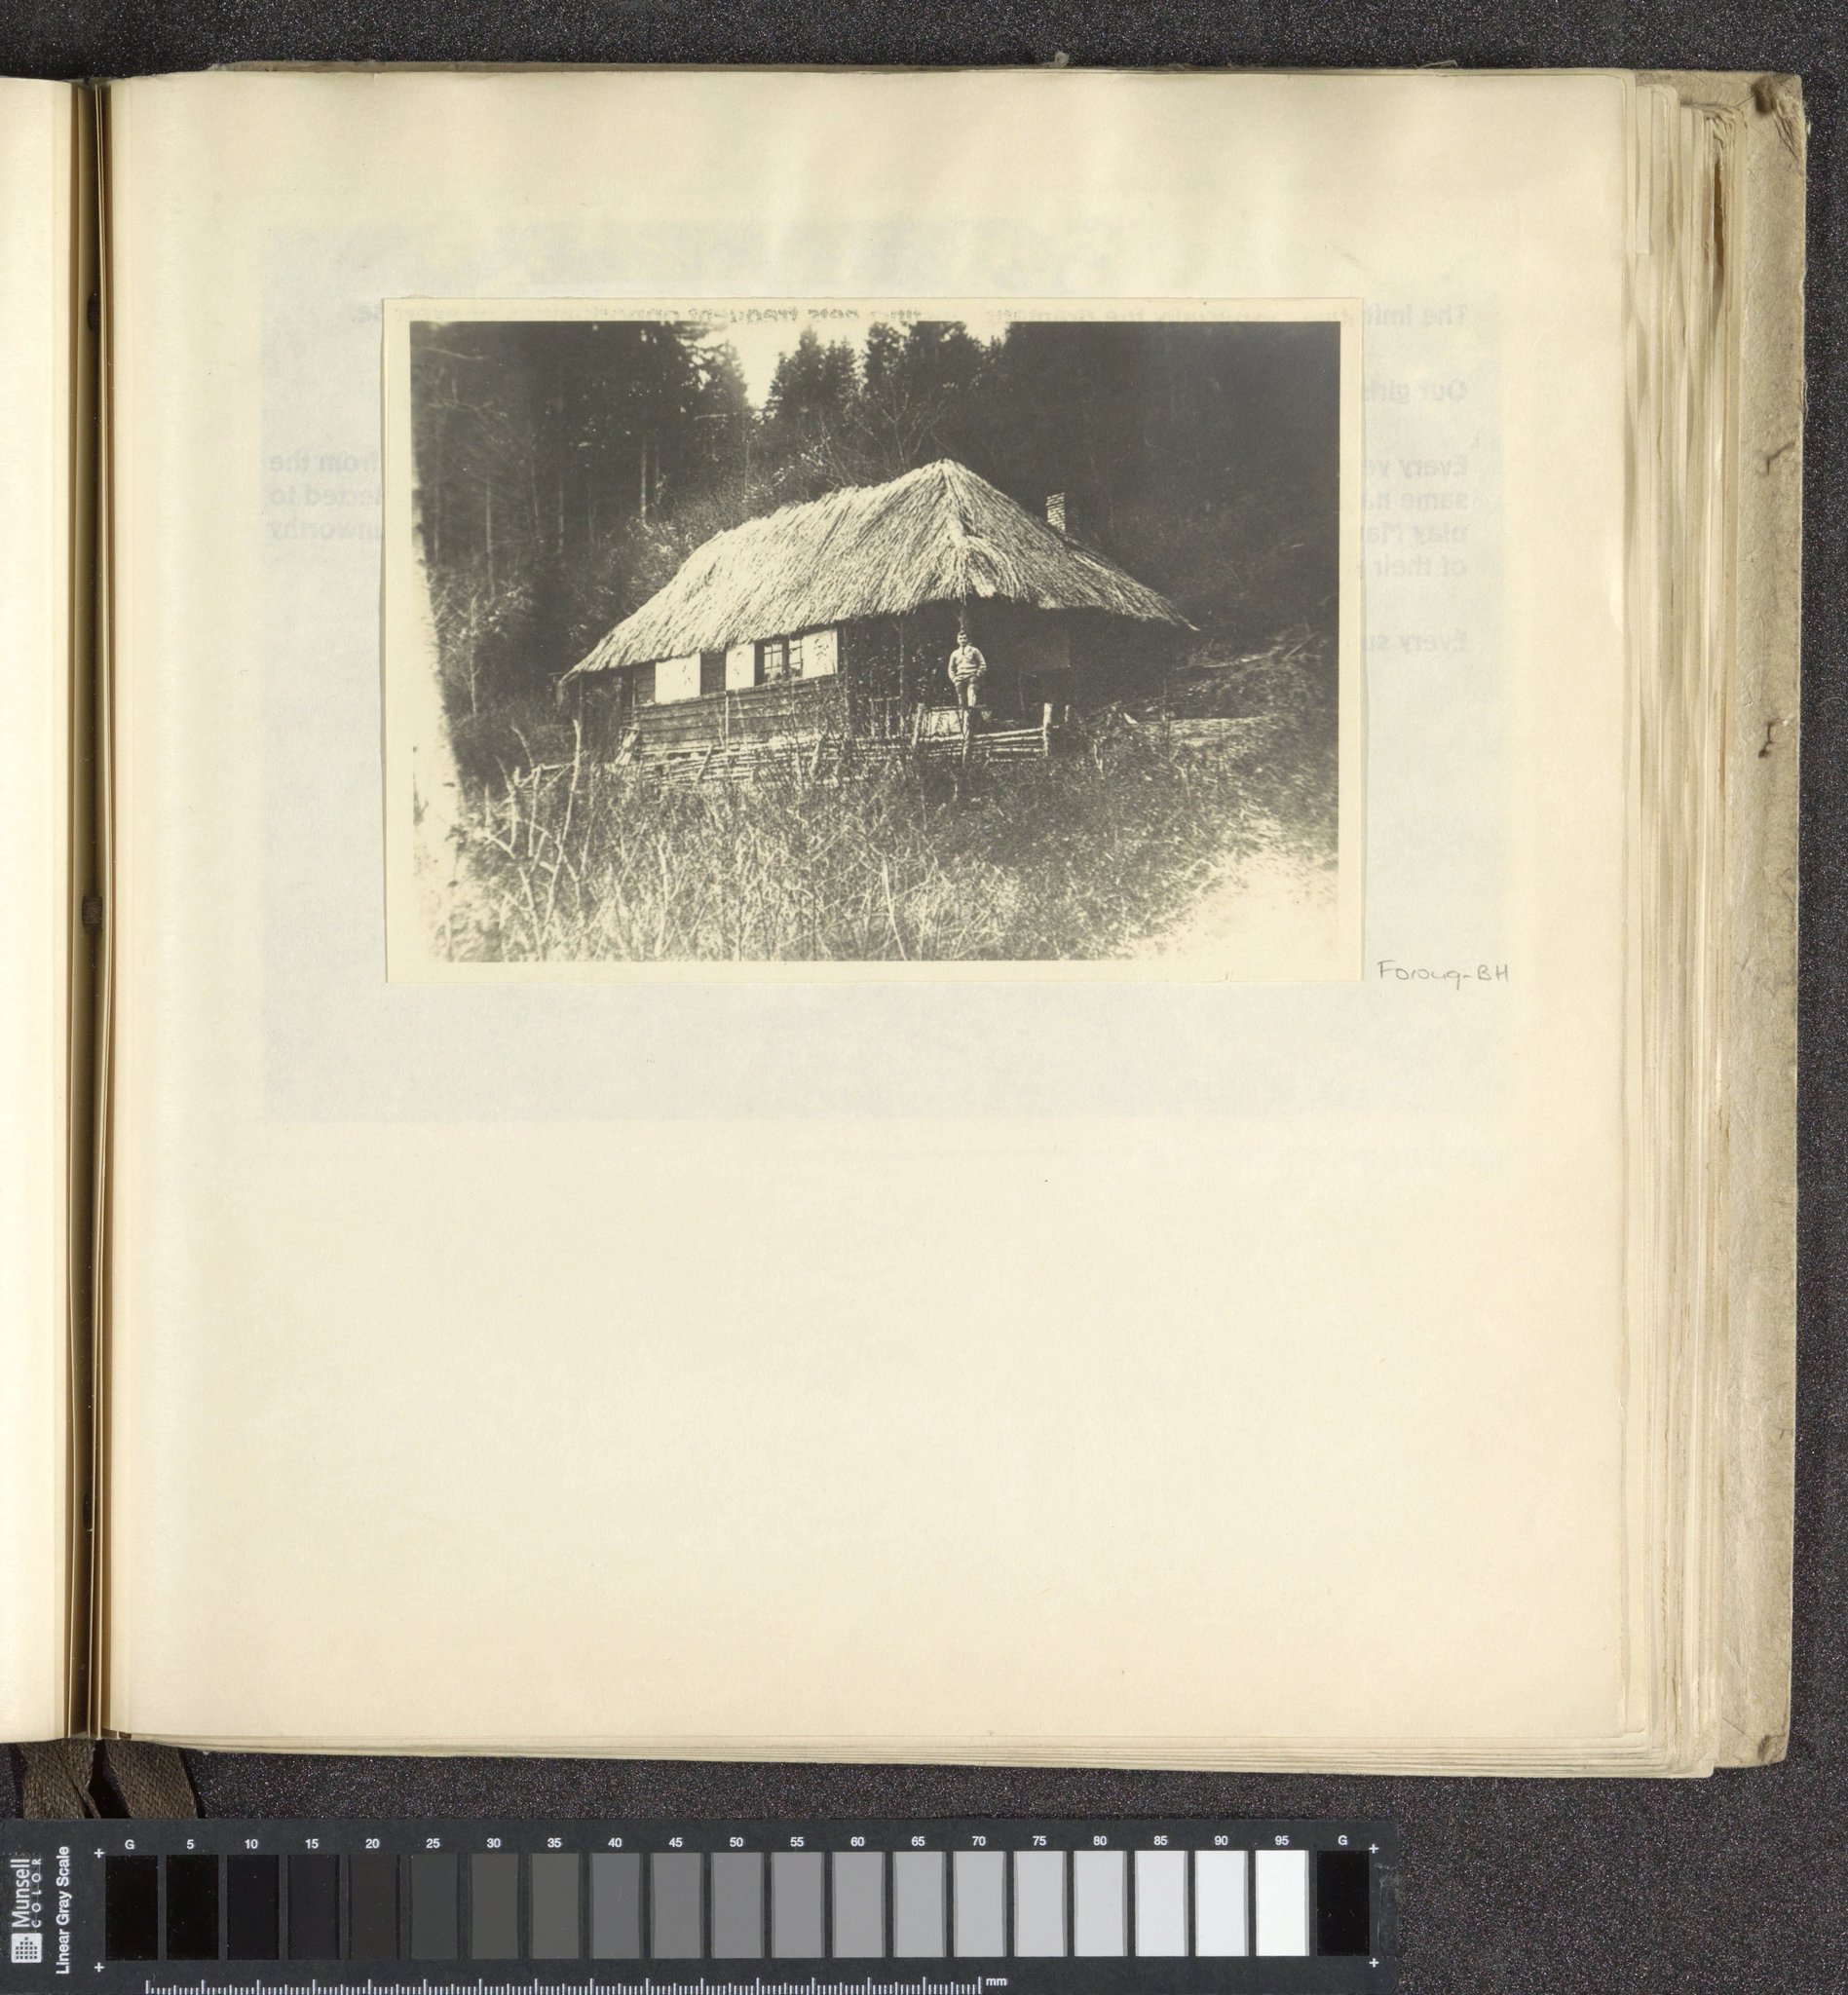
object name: photograph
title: Leerling van Schule Schloss Salem bij een zelfgebouwde blokhut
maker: Anonymous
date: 1929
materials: photographic support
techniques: gelatin silver print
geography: baden-württemberg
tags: rural housing, e.g. country-house, villa, cottage, education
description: Onderdeel van Fotoalbum van Schule Schloss Salem.